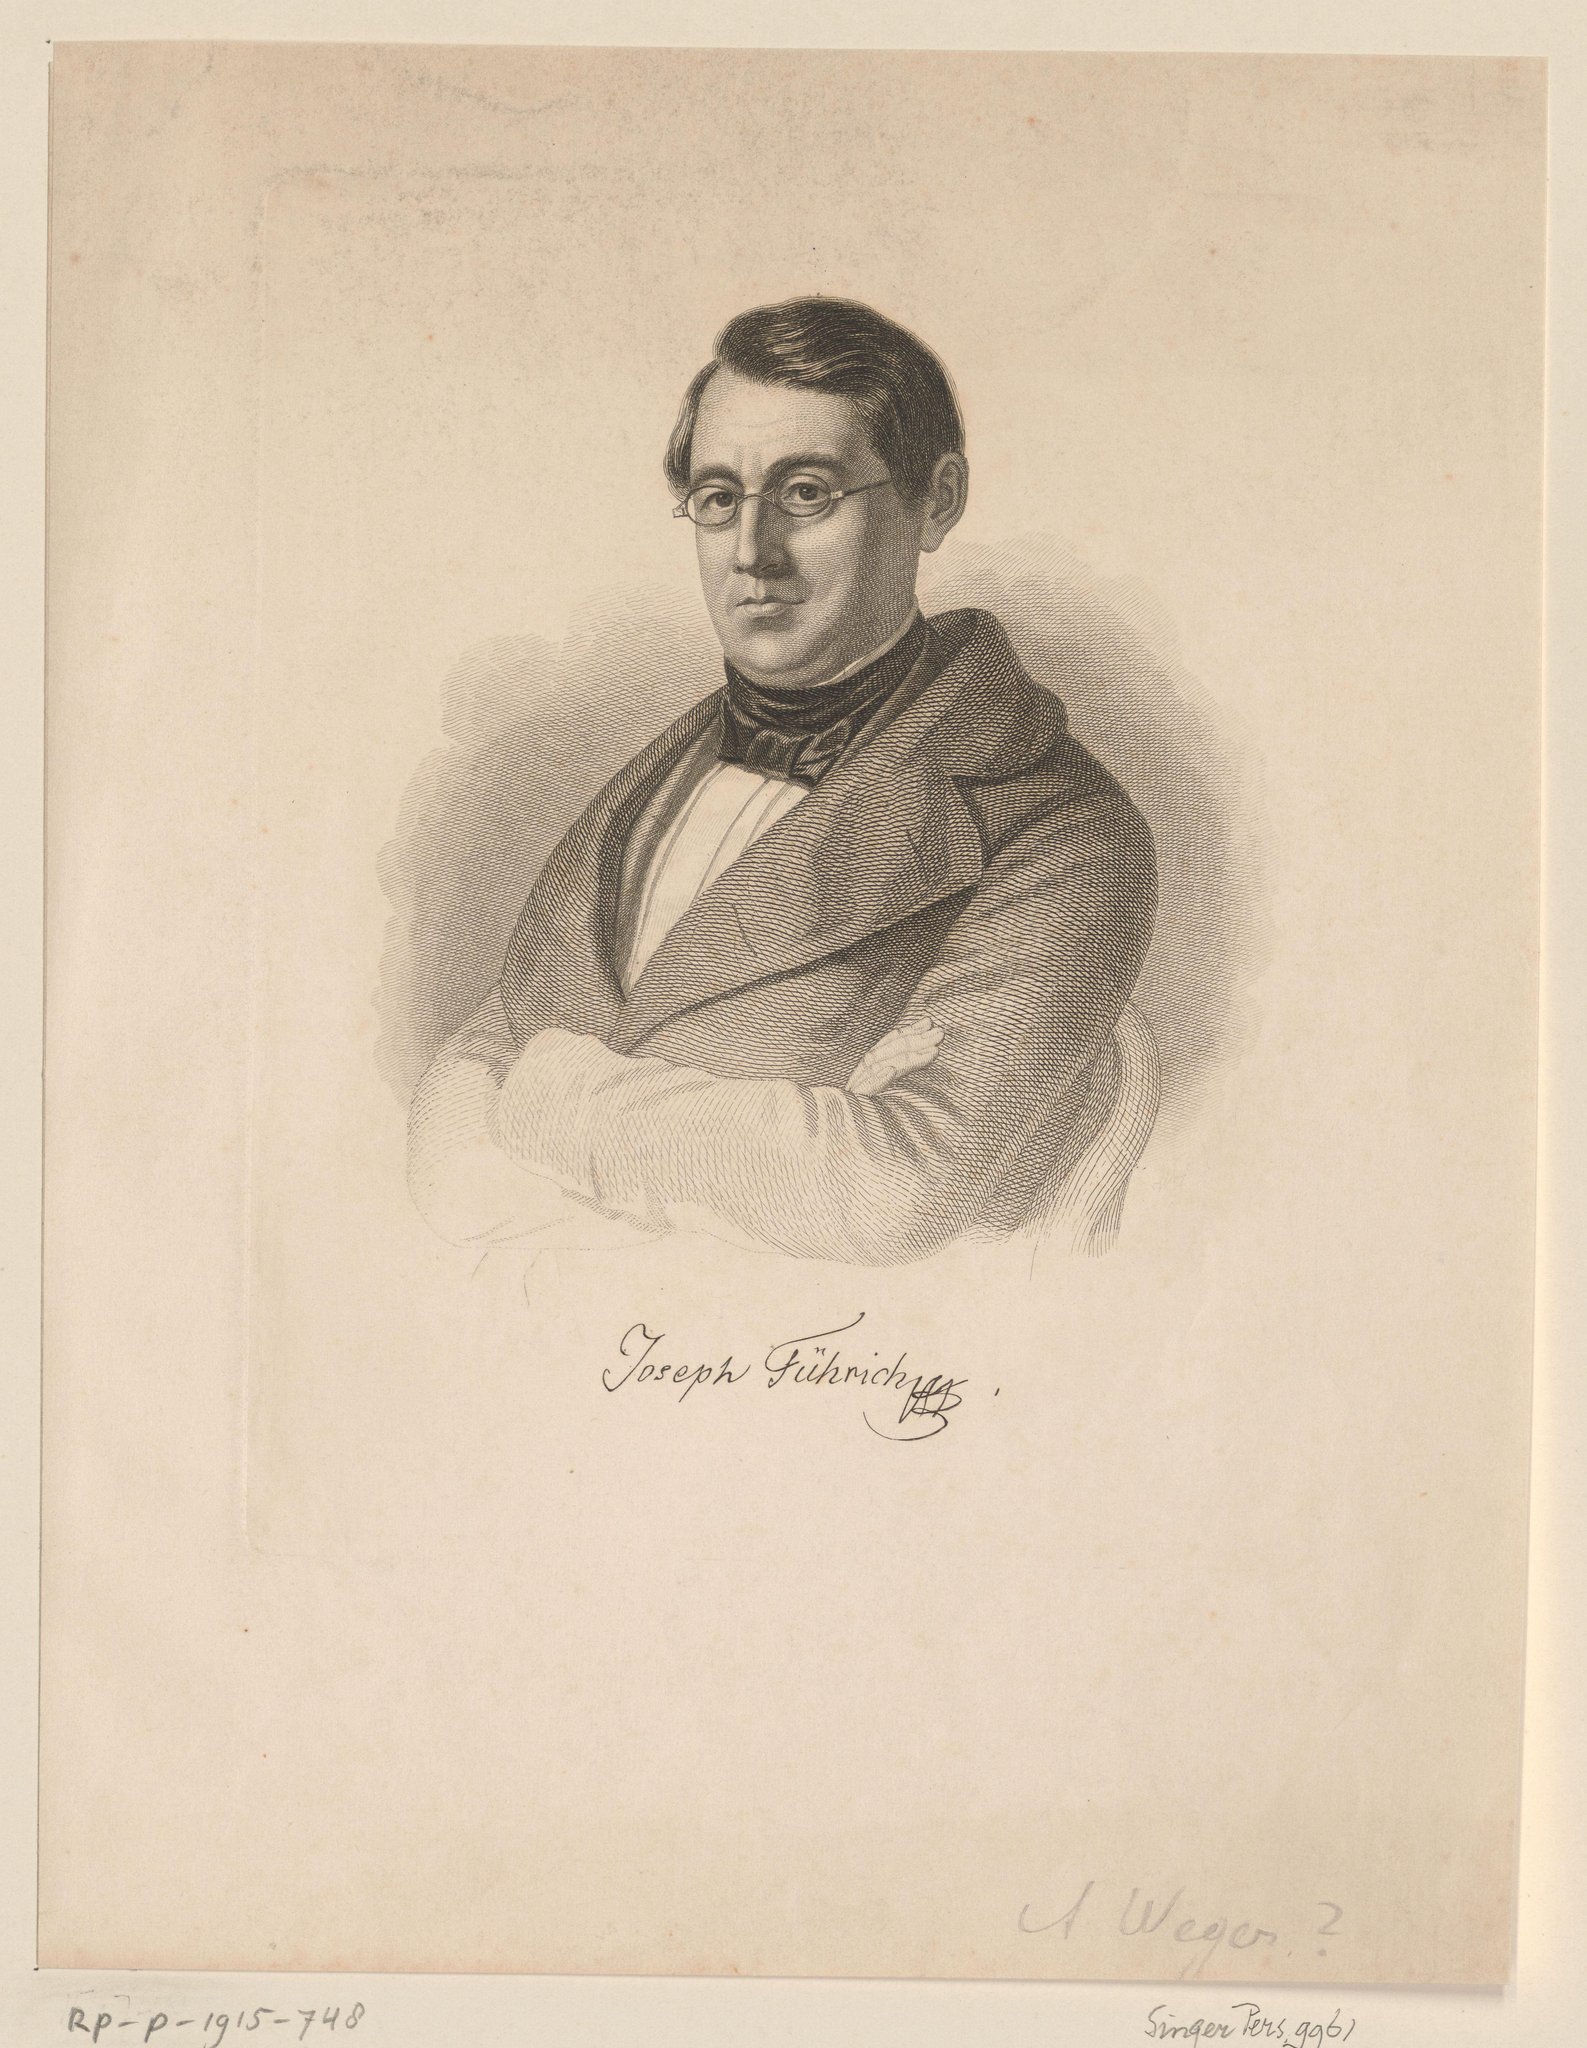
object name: print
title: Portret van Joseph von Führich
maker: august weger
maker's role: print maker, printer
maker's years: 1823-1892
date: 1849-1892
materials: paper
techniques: engraving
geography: leipzig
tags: vienna, painter, print maker, draughtsman, joseph von führich, historical persons, portrait, self-portrait of painter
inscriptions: collector's mark: Lugt 2228